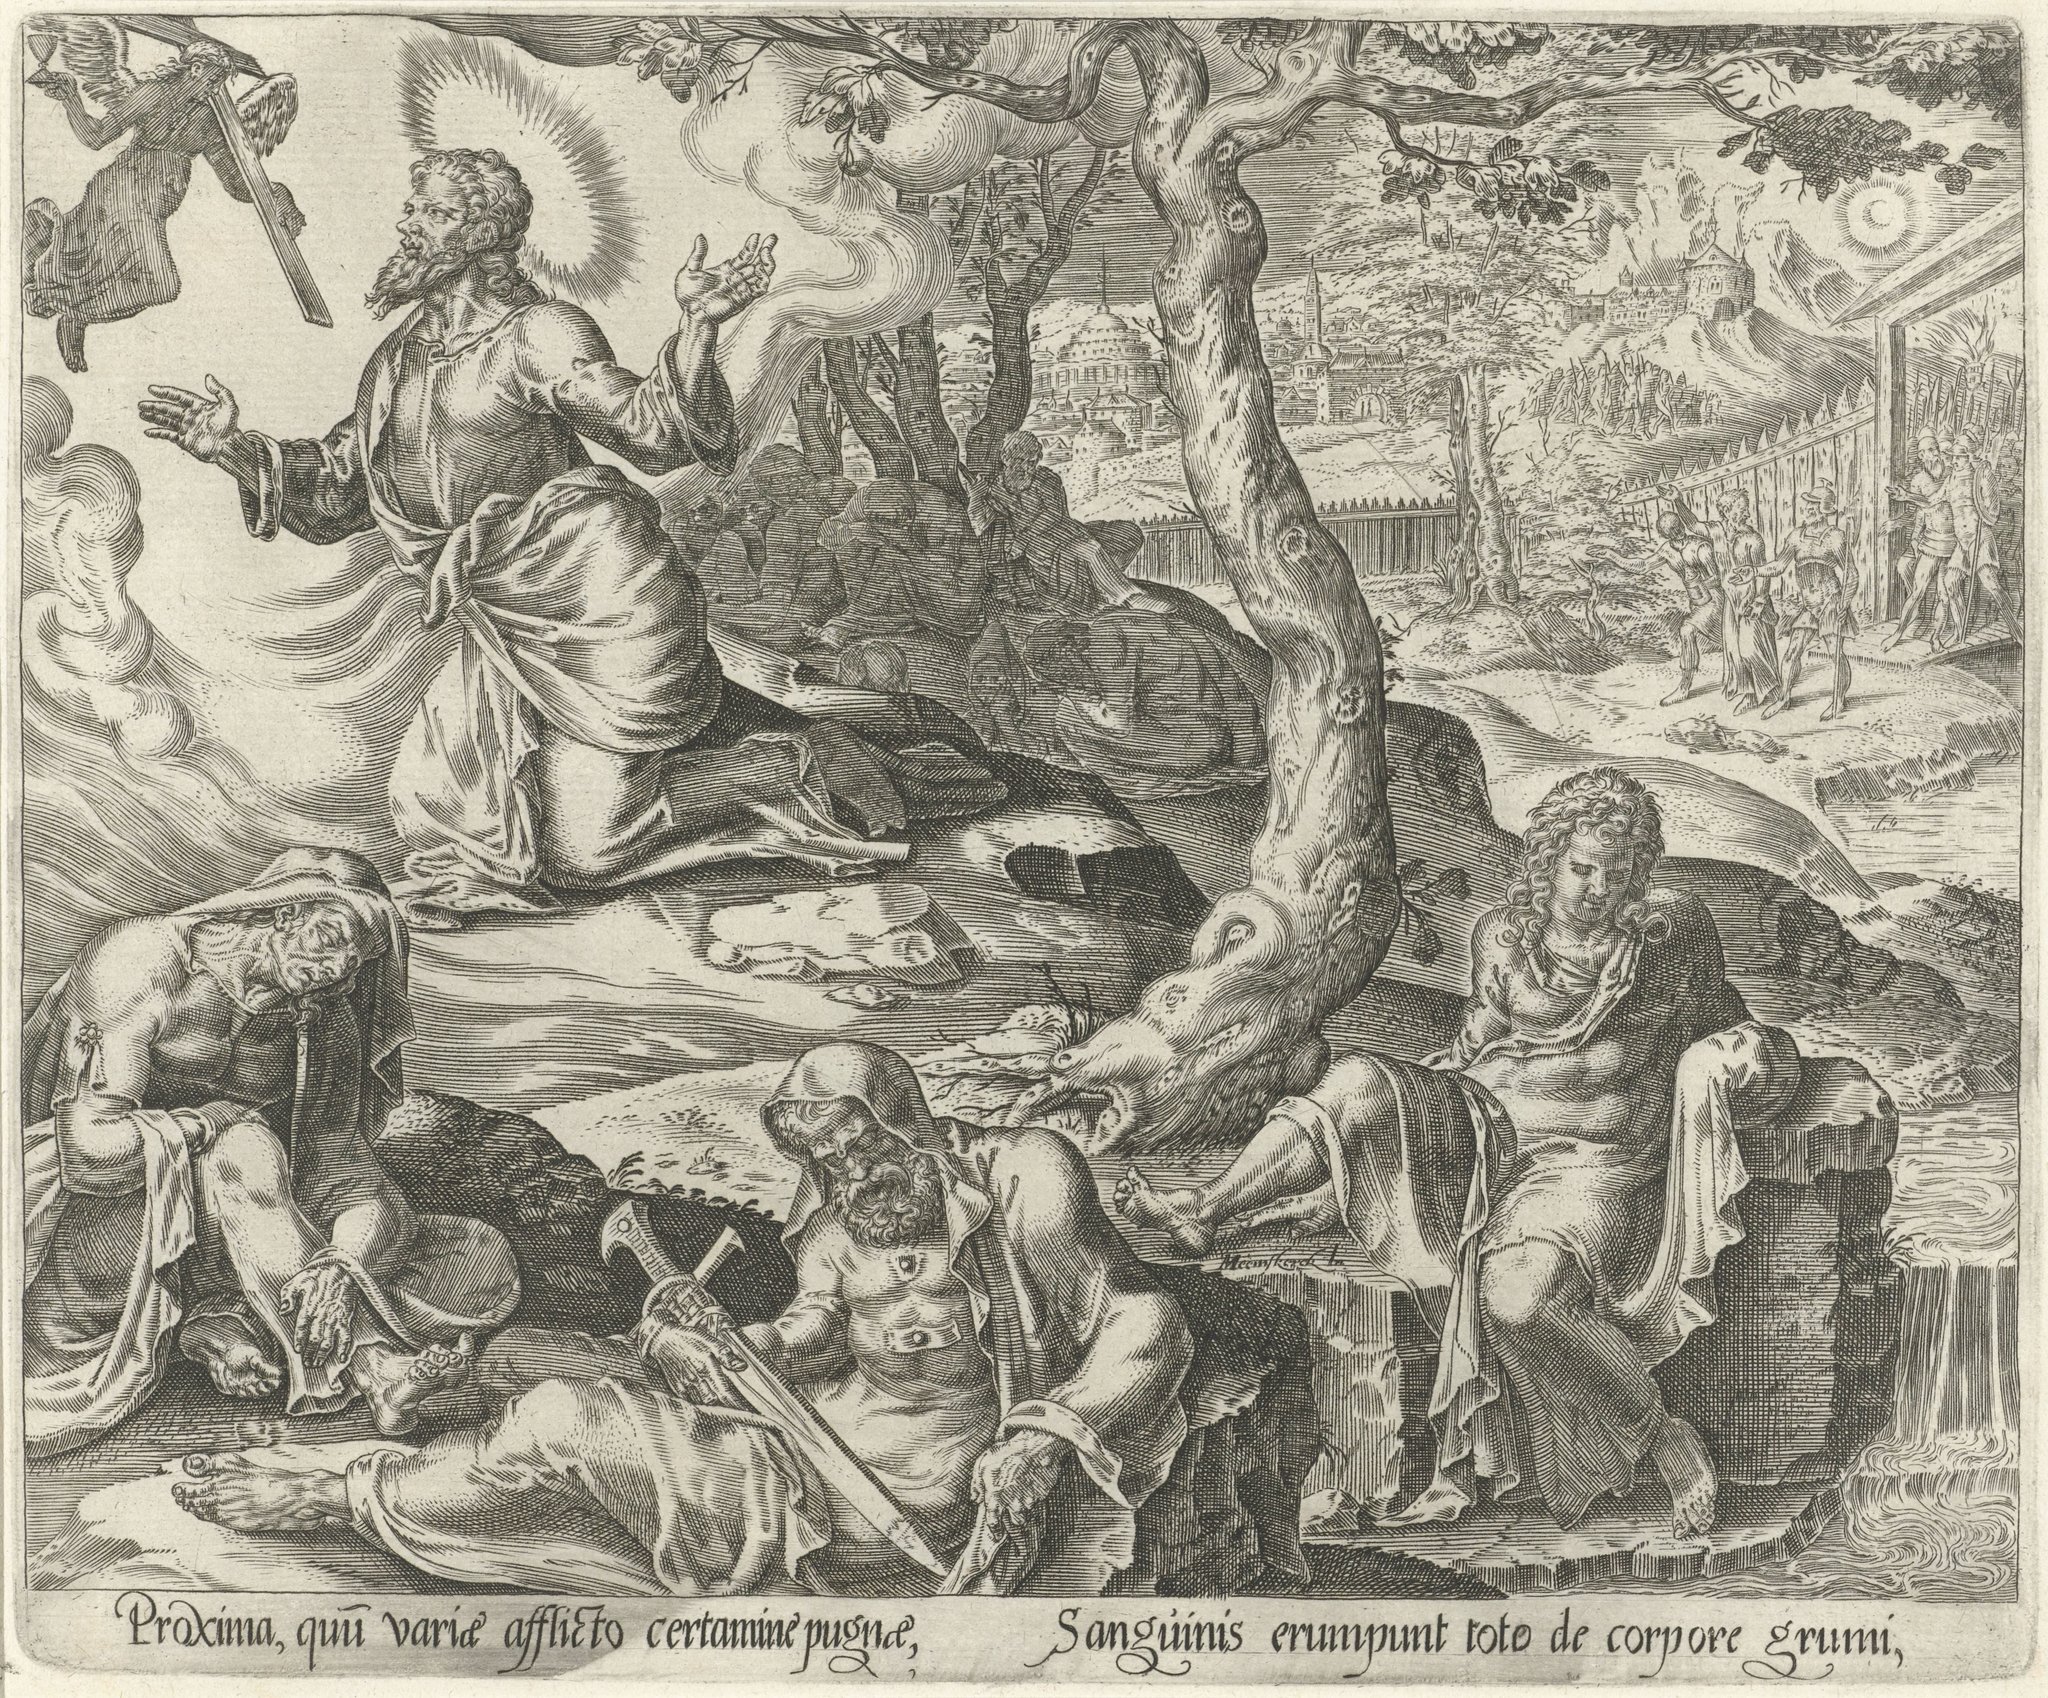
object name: print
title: Christus in de hof van Getsemane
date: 1565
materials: paper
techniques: engraving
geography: amsterdam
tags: agony of christ: to comfort him one or more angels appear to christ with chalice and/or cross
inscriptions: collector's mark: Lugt 2228, collector's mark: Lugt 2760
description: Christus biddend in doodsangst in de hof van Getsemane. Een engel presenteert hem het kruis en een kelk. Petrus, Jakobus en Johannes liggen op de voorgrond te slapen. Rechts verschijnt Judas met een groep soldaten. Onderaan in de marge een vers in het Latijn. Prent maakt deel uit van een serie over de zeven bloedingen van Christus. Tijdens het gebed in Getsemane viel zijn zweet als bloeddruppels op de grond.